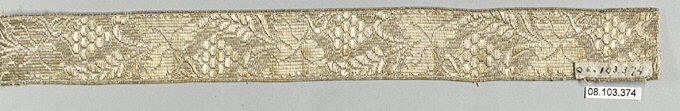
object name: galloon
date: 1601-1800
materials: metal thread